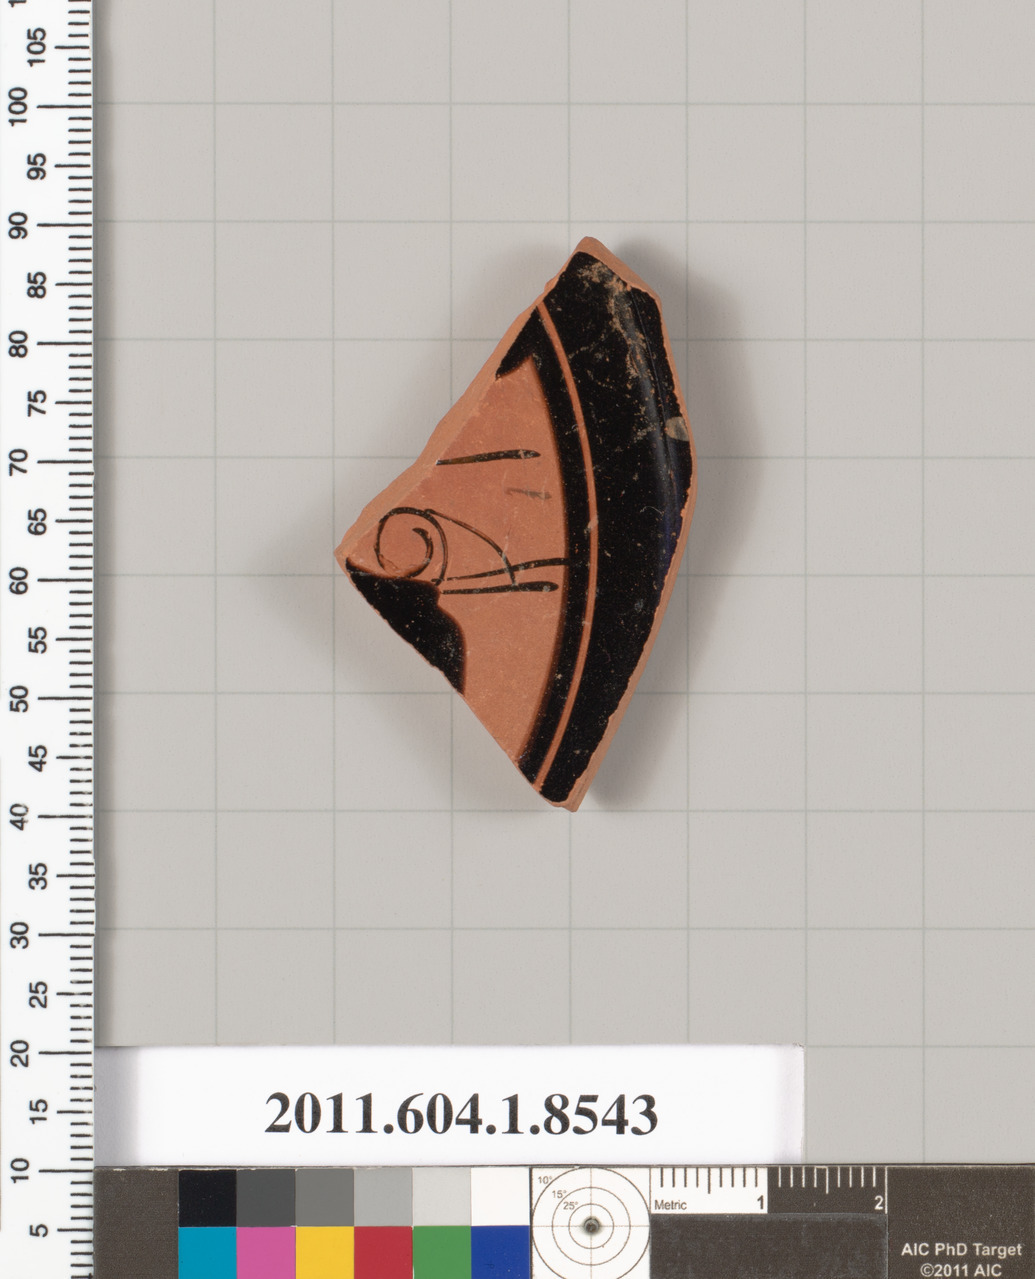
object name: kylix fragment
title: Terracotta fragment of a stemless kylix (drinking cup)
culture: greek, attic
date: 467-435 BCE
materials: terracotta